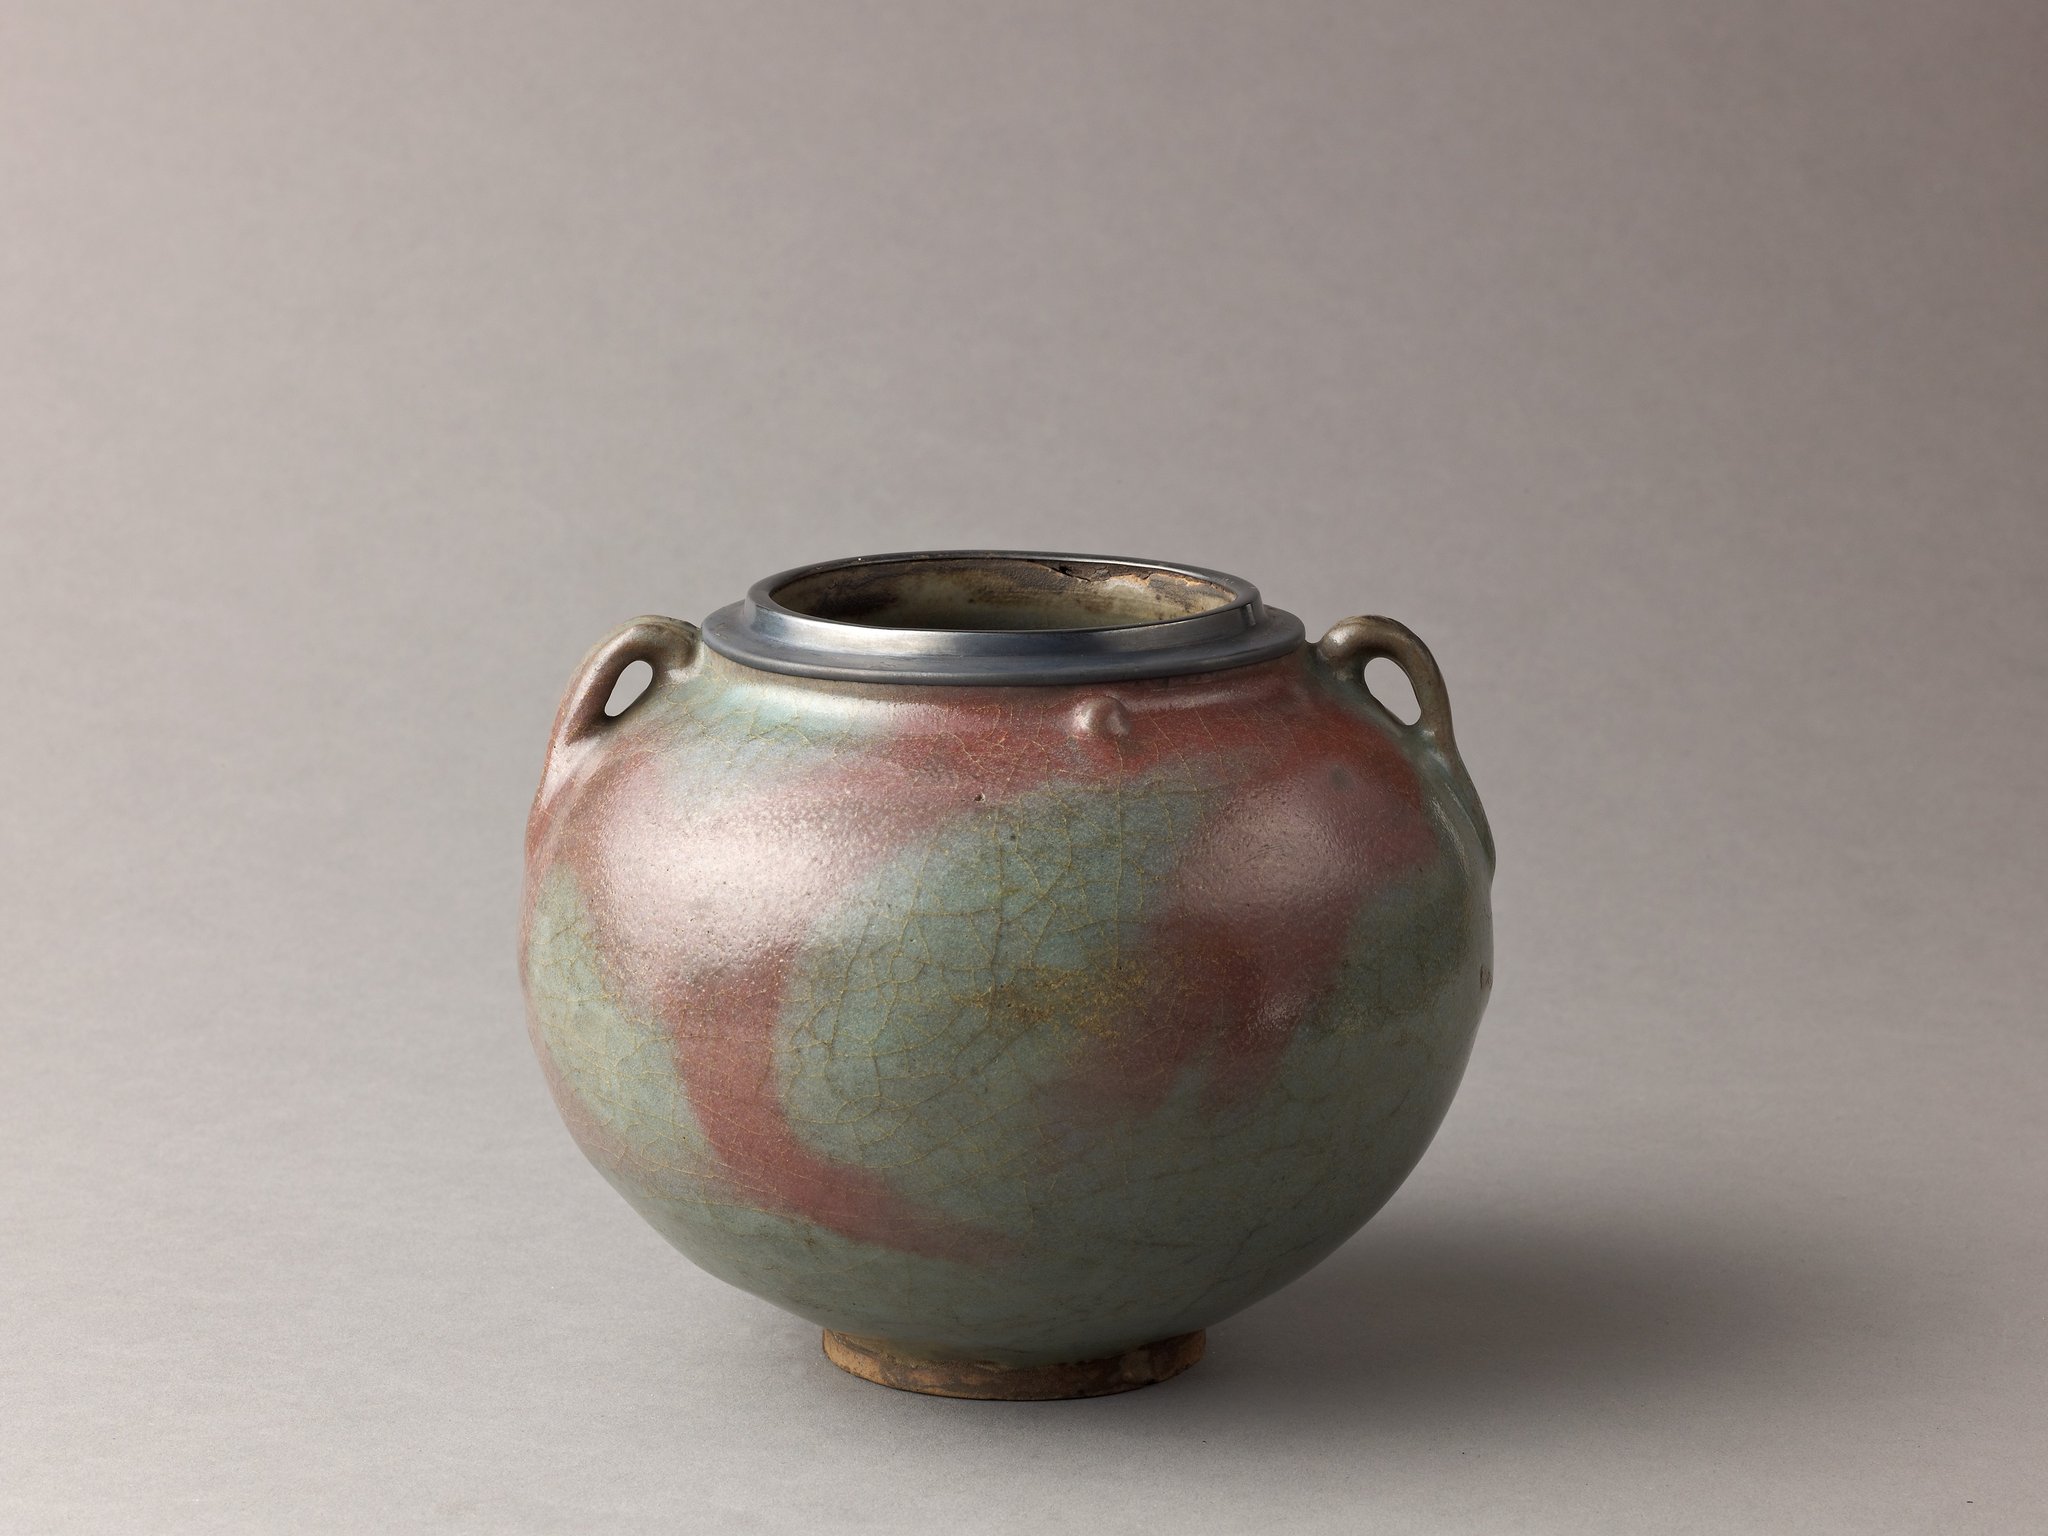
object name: jar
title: Two-eared jar, Jun ware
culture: chinese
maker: chinese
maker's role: artist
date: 1201-1300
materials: glaze, stoneware